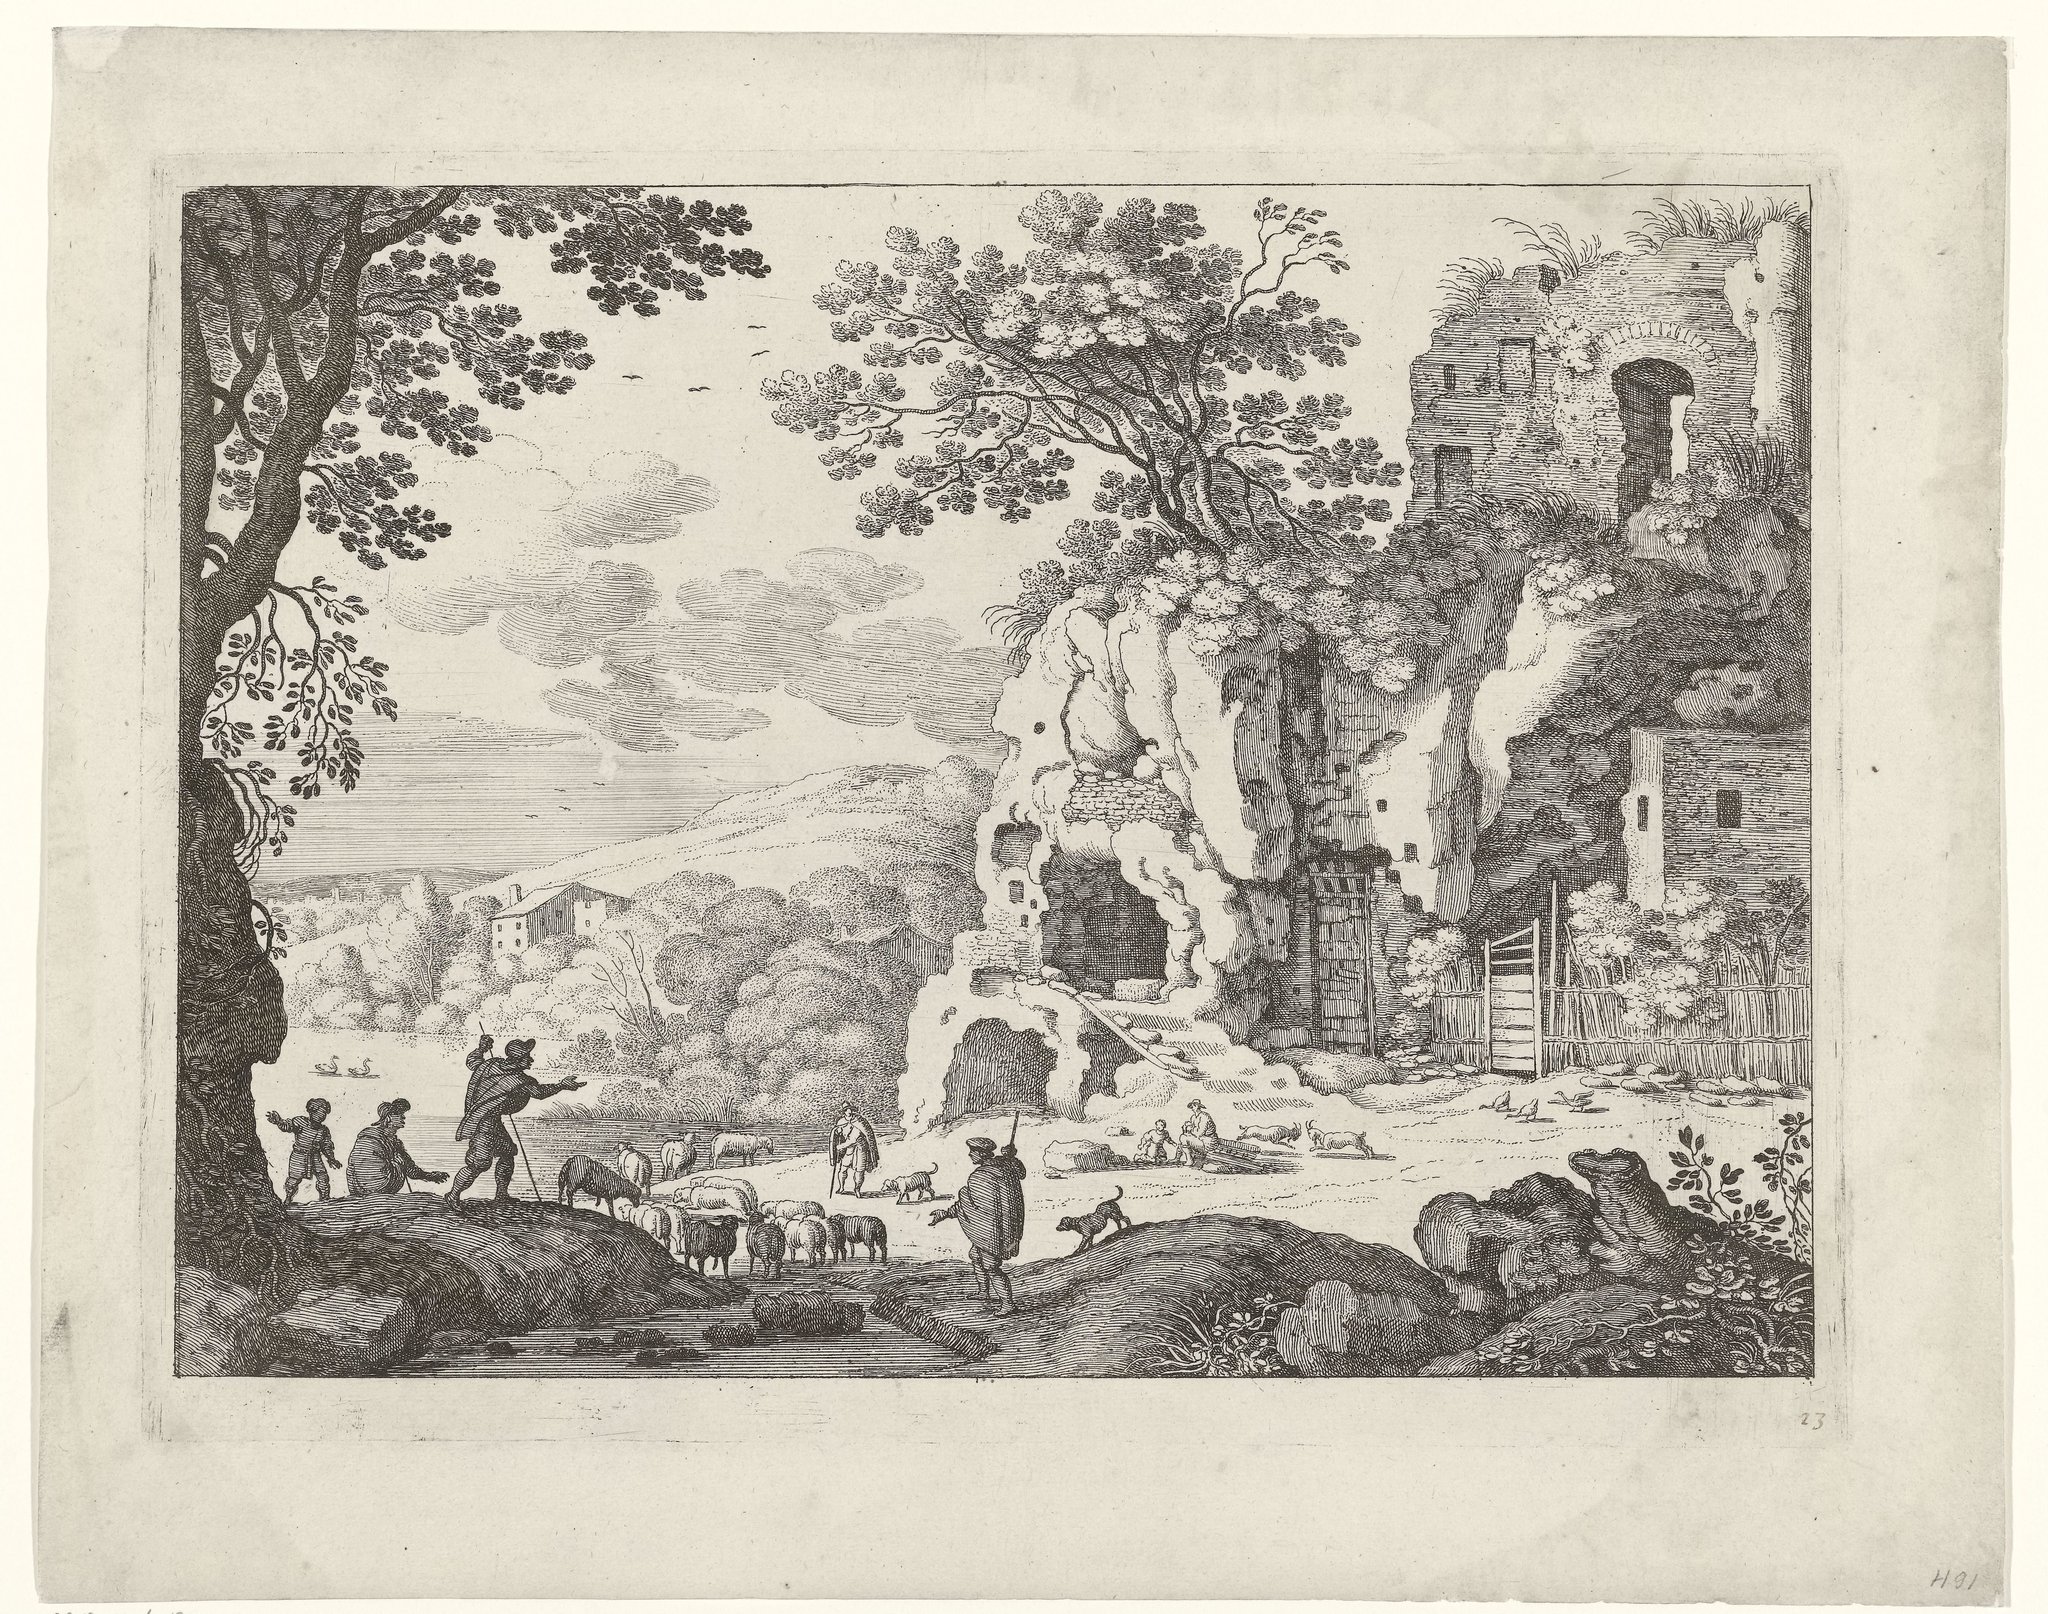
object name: print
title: Italiaanse landschappen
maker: guilliam van nieulandt (ii)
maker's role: draughtsman, print maker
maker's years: 1584-1635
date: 1594-1635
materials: paper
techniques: engraving, etching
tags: herding, herdsman, herdswoman, shepherd, shepherdess, cowherd, etc., landscape with ruins, lake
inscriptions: number: ‘23’, collector's mark: Lugt 2760, collector's mark: Lugt 2228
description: Voor een ruïne op een rots lopen verschillende herders met schapen en honden. Links op de achtergrond een meer. Prent uit een serie Italiaanse landschappen.